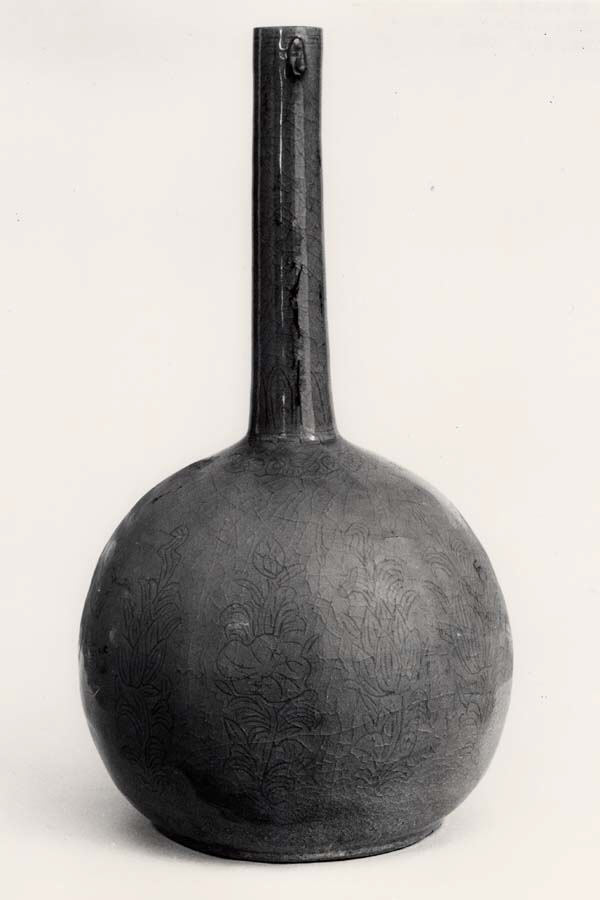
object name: bottle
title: Bottle with Lotus Pond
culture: korean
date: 1101-1150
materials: ceramic glaze, glaze, stoneware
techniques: incising